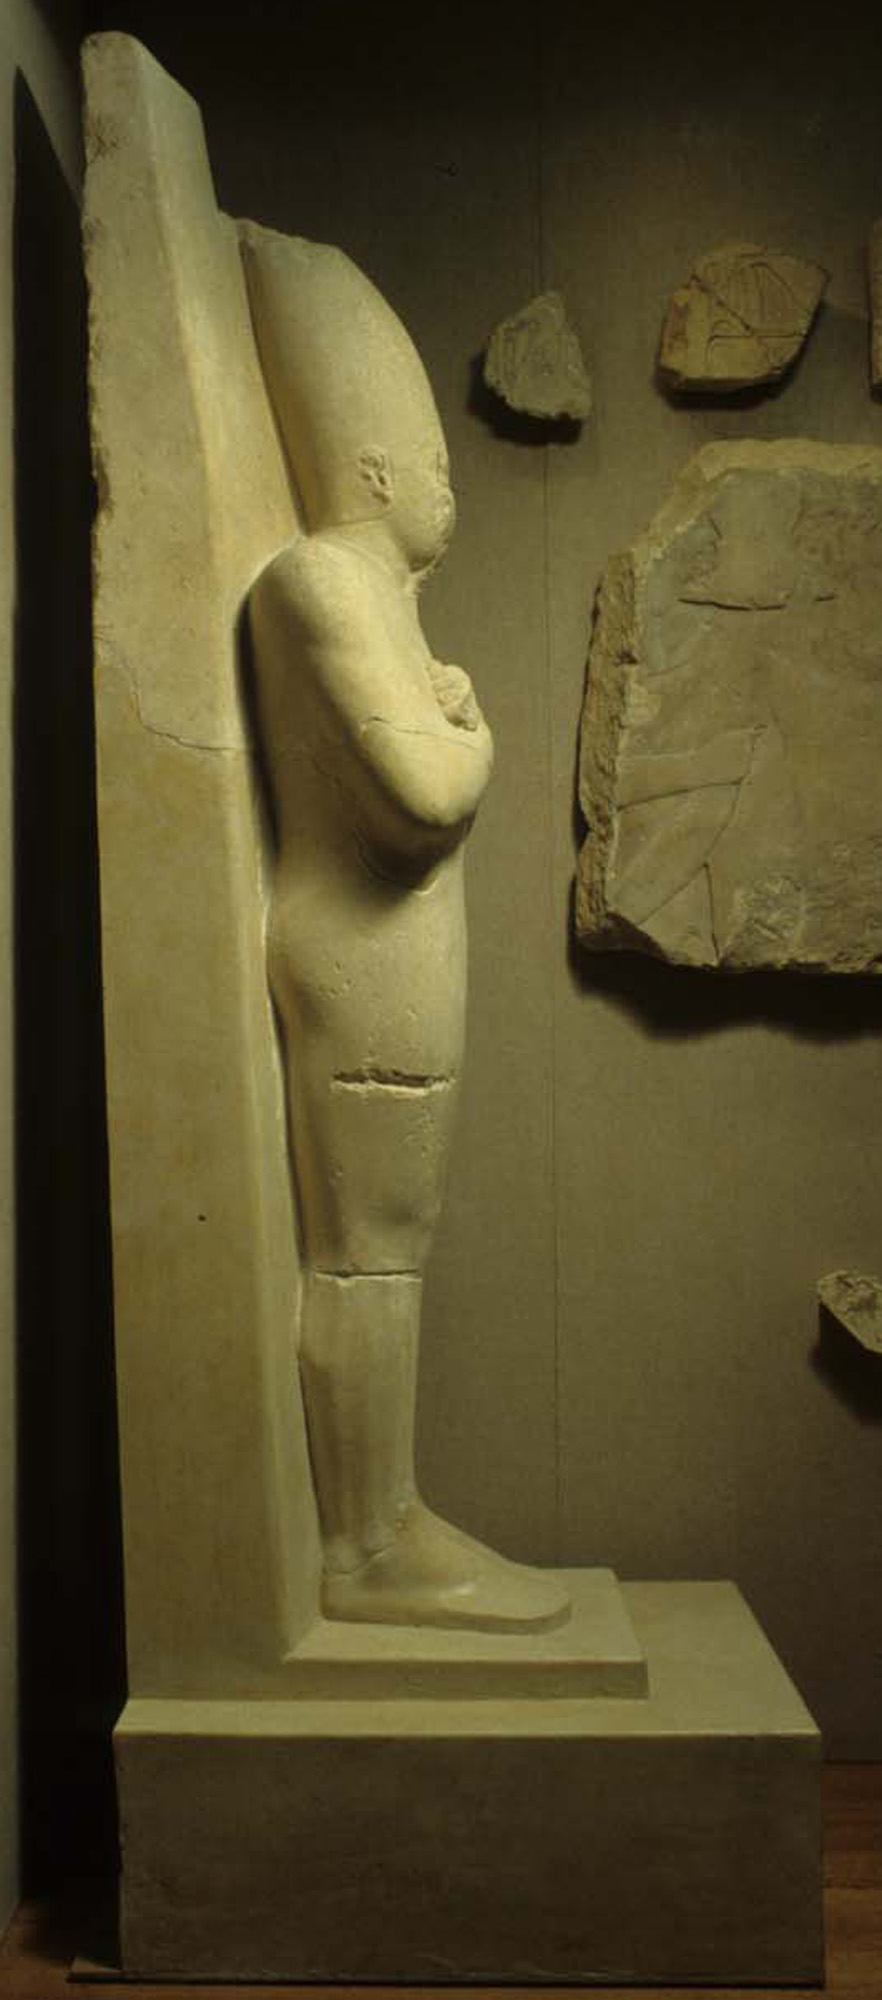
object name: statue, senwosret i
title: Osiride statue of Senwosret I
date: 1961-1917 BCE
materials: limestone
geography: egypt